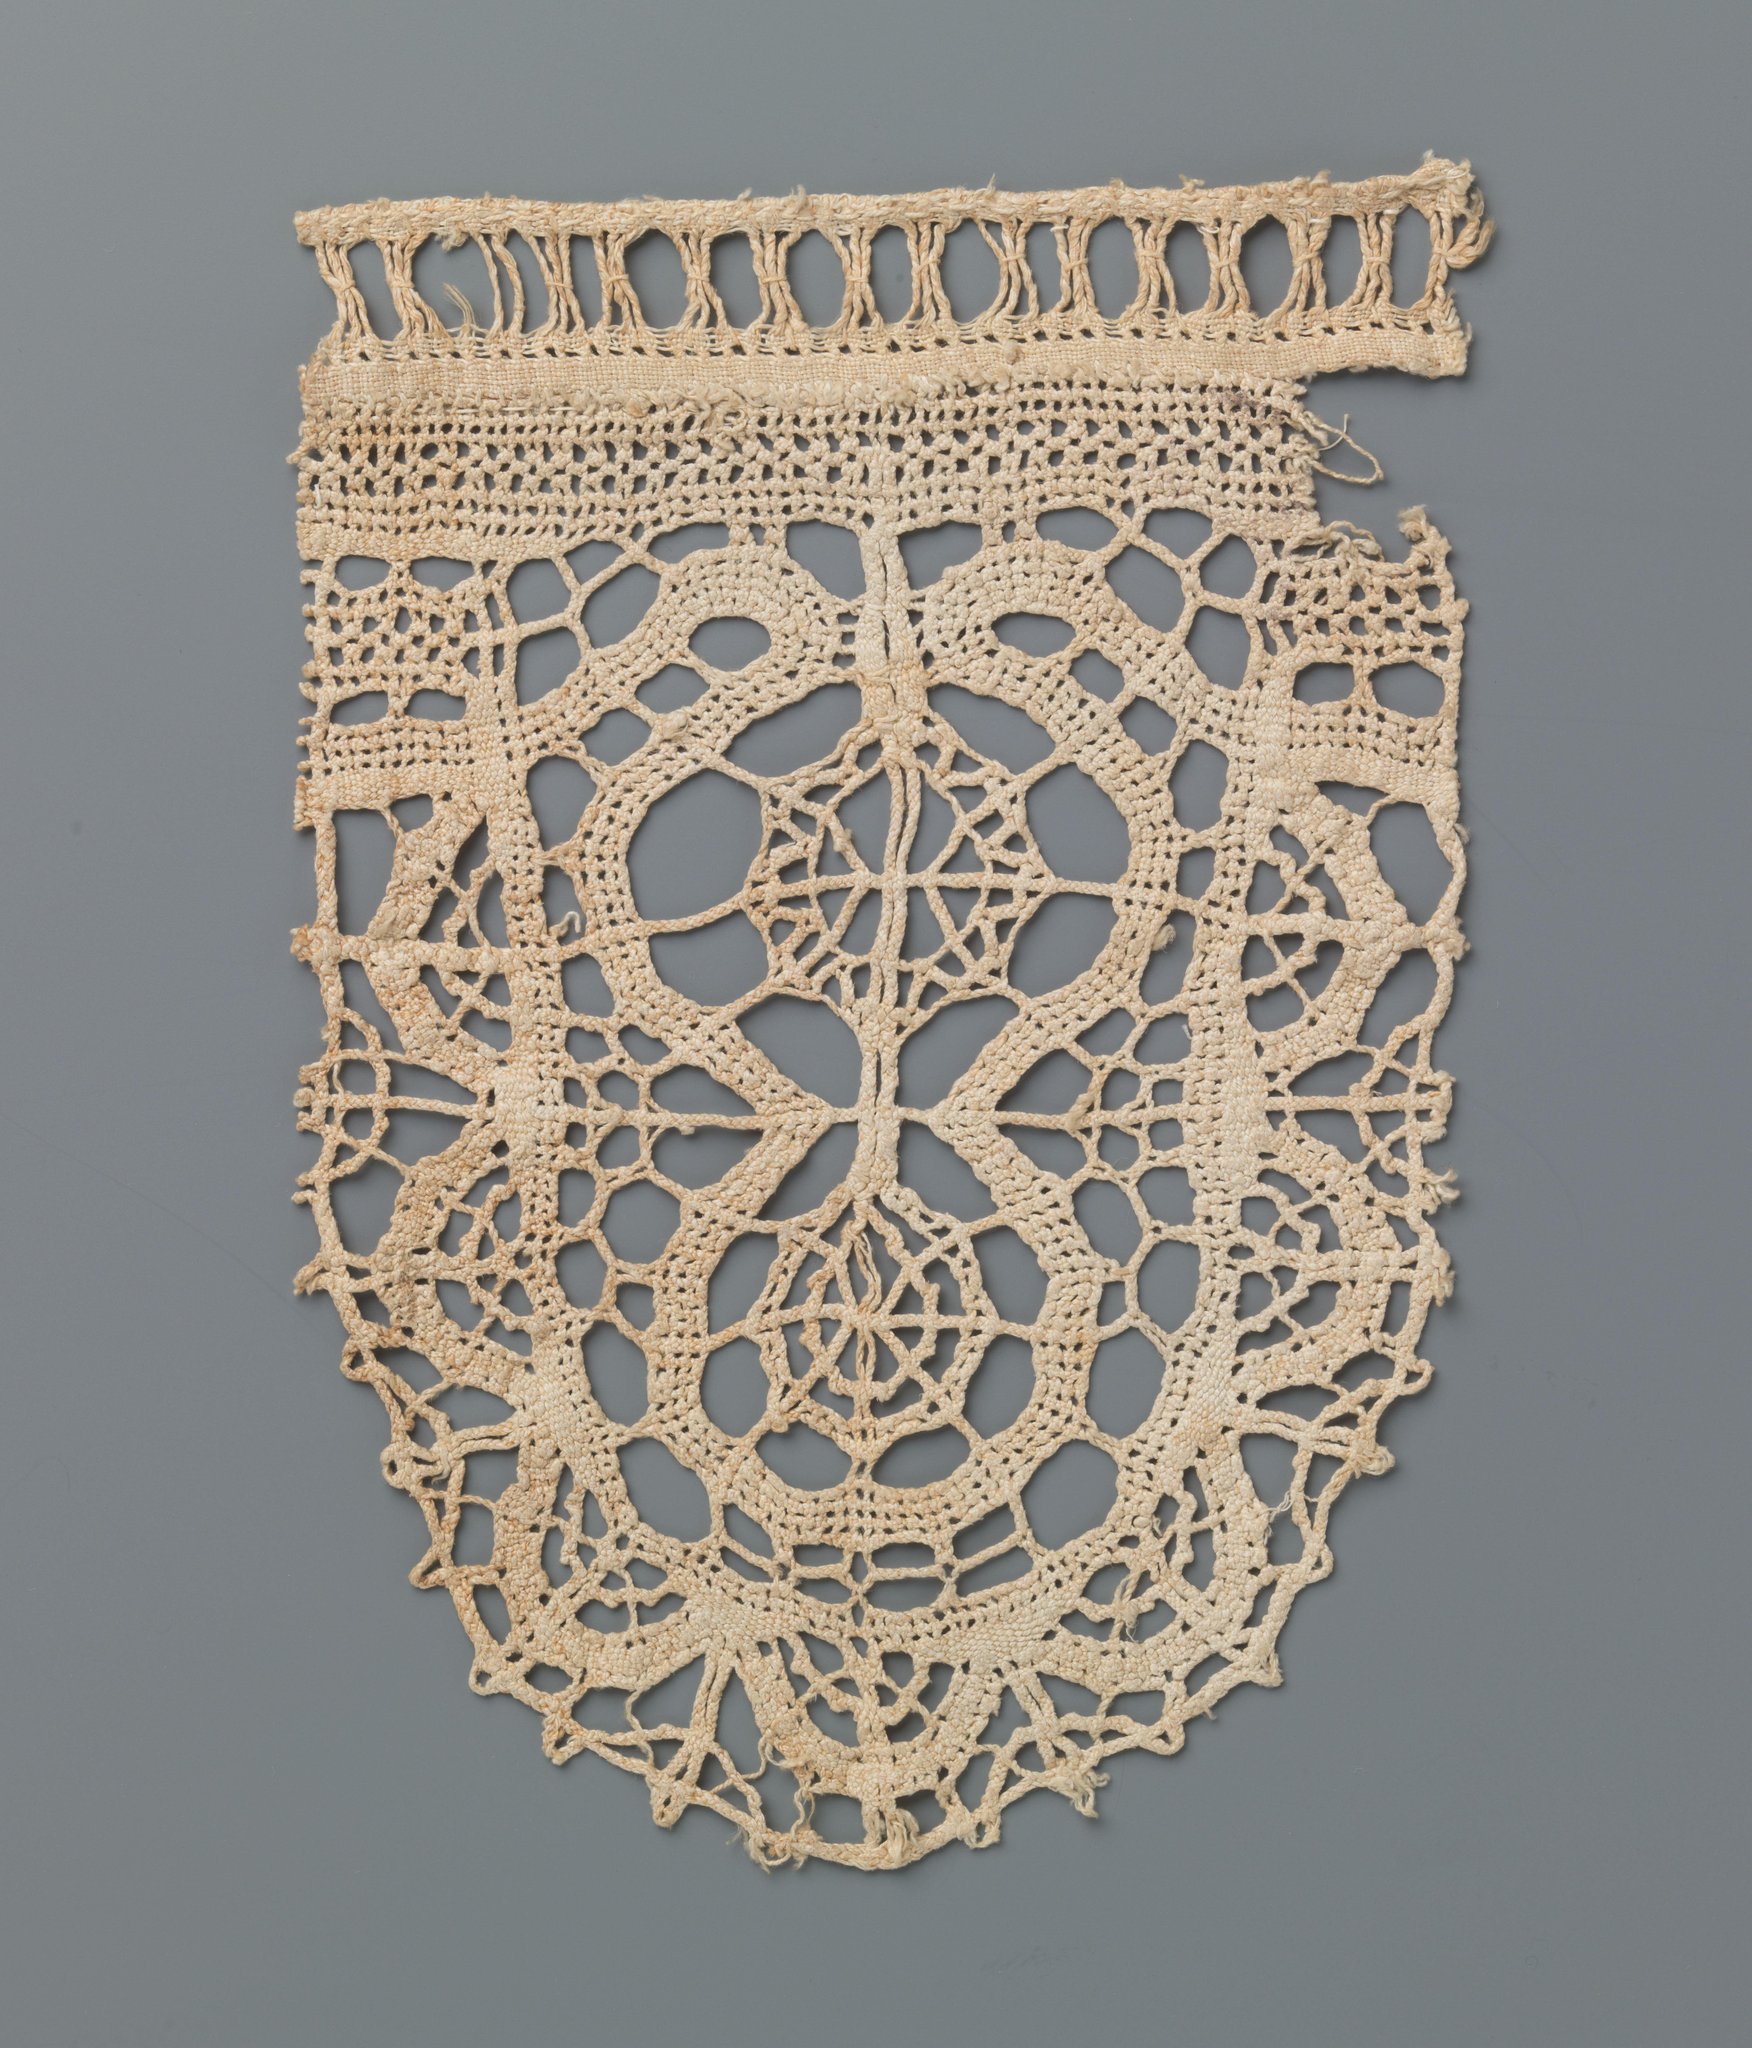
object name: schulp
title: Fragment kloskant bestaande uit één schulp met twee wielen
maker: Anonymous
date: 1600-1624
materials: linen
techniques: lace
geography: genoa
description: Fragment van naturelkleurige Genuese kloskant. Het fragment bestaat uit één half ovaalvormige schulp en is vermoedelijk een deel van een strook. Langs de ronding van de halve ovaal staan boven elkaar twee in elkaar overlopende cirkels met in elke cirkel een wiel. De halve ovaal is zelf afgezet met zeven halfcirkelvormige schulpen. De lintvormige motieven zijn door een vlechtengrond met elkaar verbonden. De bovenkant van de schulp is afgezet met een strookje linnen met kantborduurwerk, werk met samengetrokken draden.